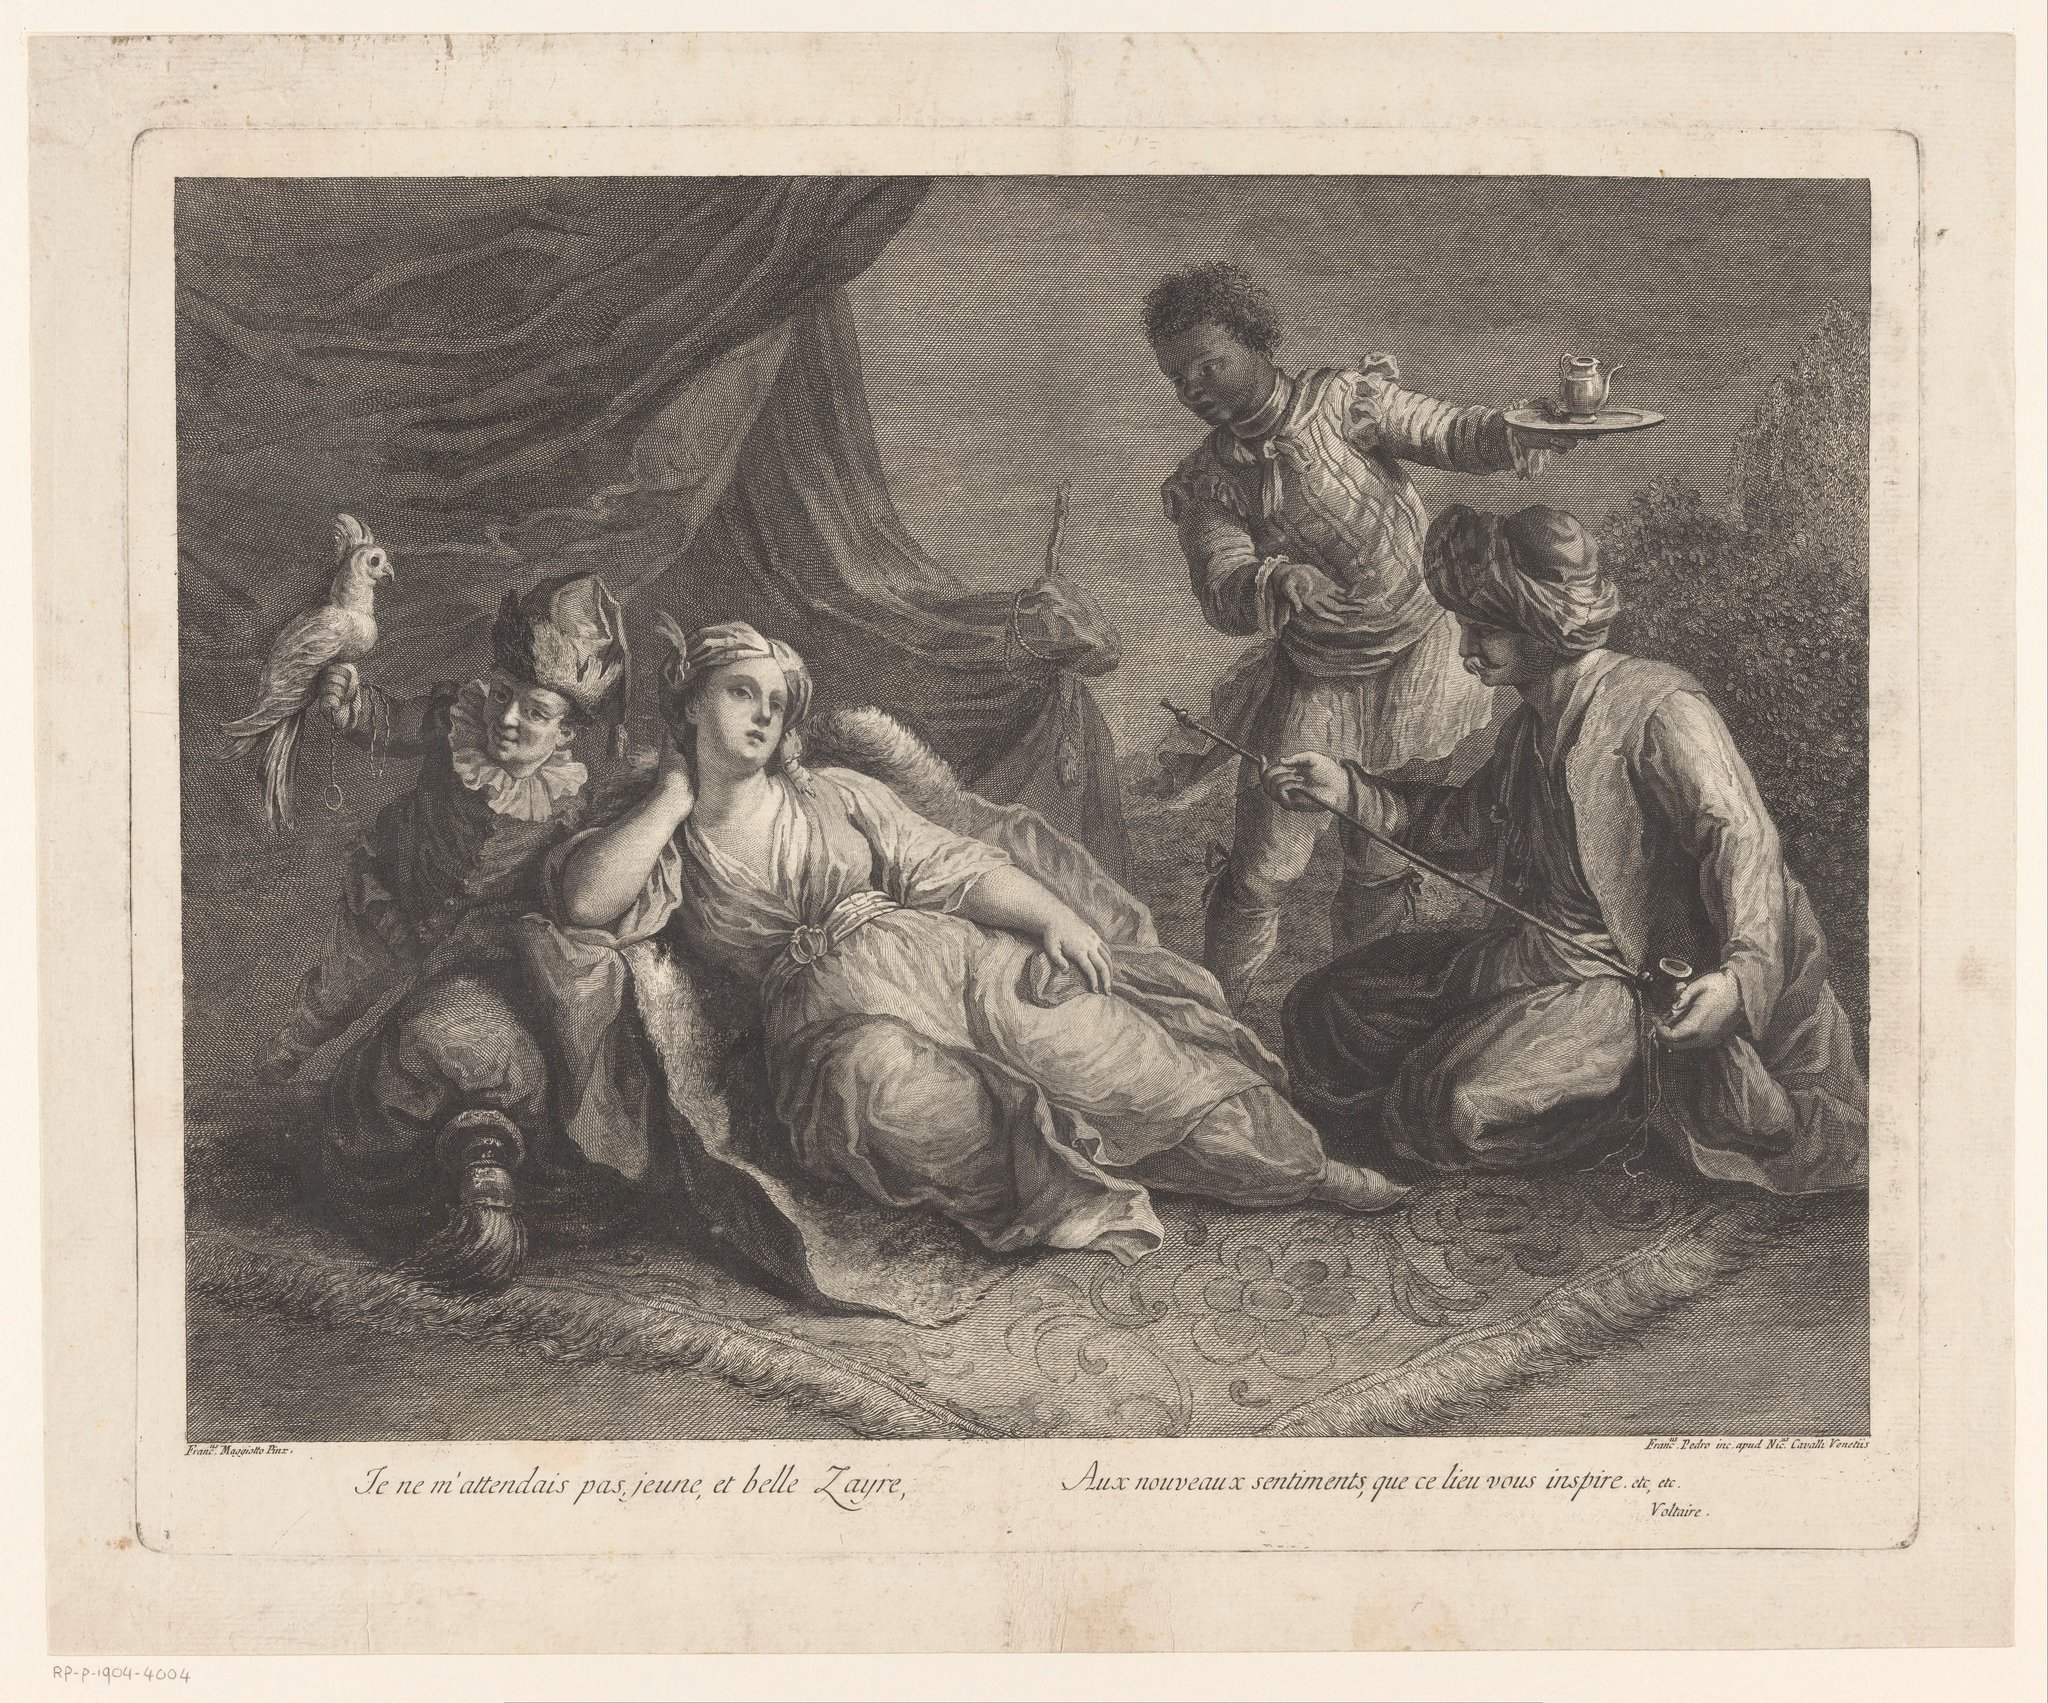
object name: print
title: Vrouw liggend op een kleed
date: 1750-1806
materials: paper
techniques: engraving, etching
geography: italy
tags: other birds, pipe ~ tobacco, head-gear: turban, house personnel, servants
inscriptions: collector's mark: Lugt 2228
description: Scène uit het toneelstuk 'Zaïre' van Voltaire. Een vrouw ligt buiten op een kleed. Links naast haar een kind met een papegaai. Rechts een man met een tulband en een pijp in zijn handen. Naast hen staat een bediende met een kleine kan op een dienblad. In de ondermarge een regel tekst in het Frans.